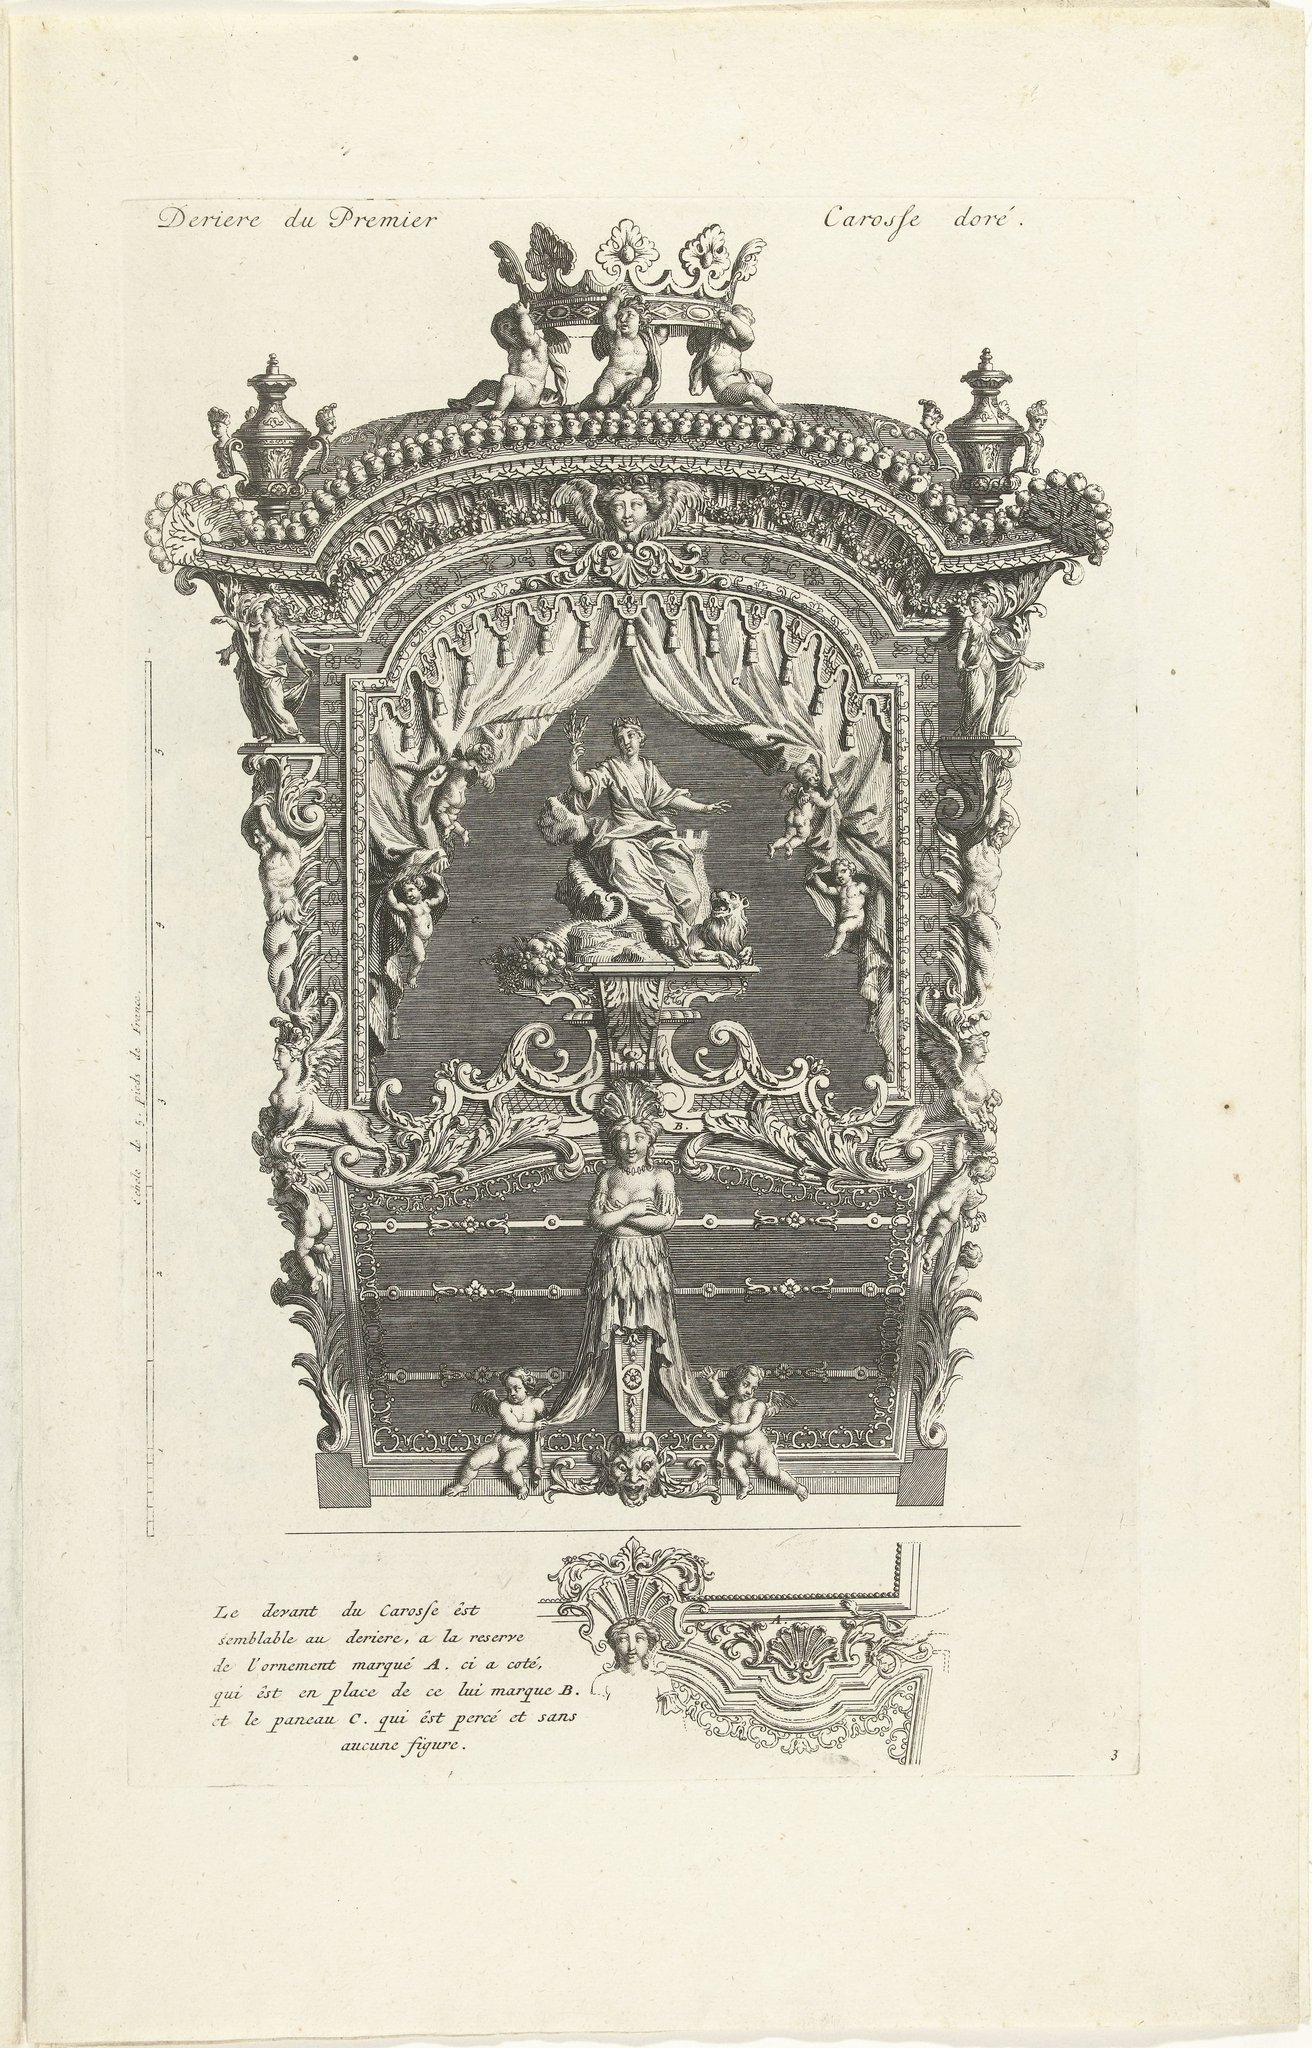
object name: print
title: Deriere du Premier Carosse doré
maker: bernard picart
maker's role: draughtsman, print maker, publisher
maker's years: 1673-1733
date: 1714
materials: paper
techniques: engraving, etching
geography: amsterdam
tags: four-wheeled, animal-drawn vehicle, e.g.: cab, carriage, coach, utrecht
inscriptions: collector's mark: Lugt 2228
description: Achterkant van de gouden koets met een paneel waarop een allegorische figuur van de Overvloed die Vrede brengt. Onderdeel van een serie van 7 platen met de statiekoets van de Spaanse gezant de hertog van Ossuna, gebruikt bij zijn openbare intocht in Utrecht voor de vredesonderhandelingen in 1713. Genummerd rechtsonder: 3.